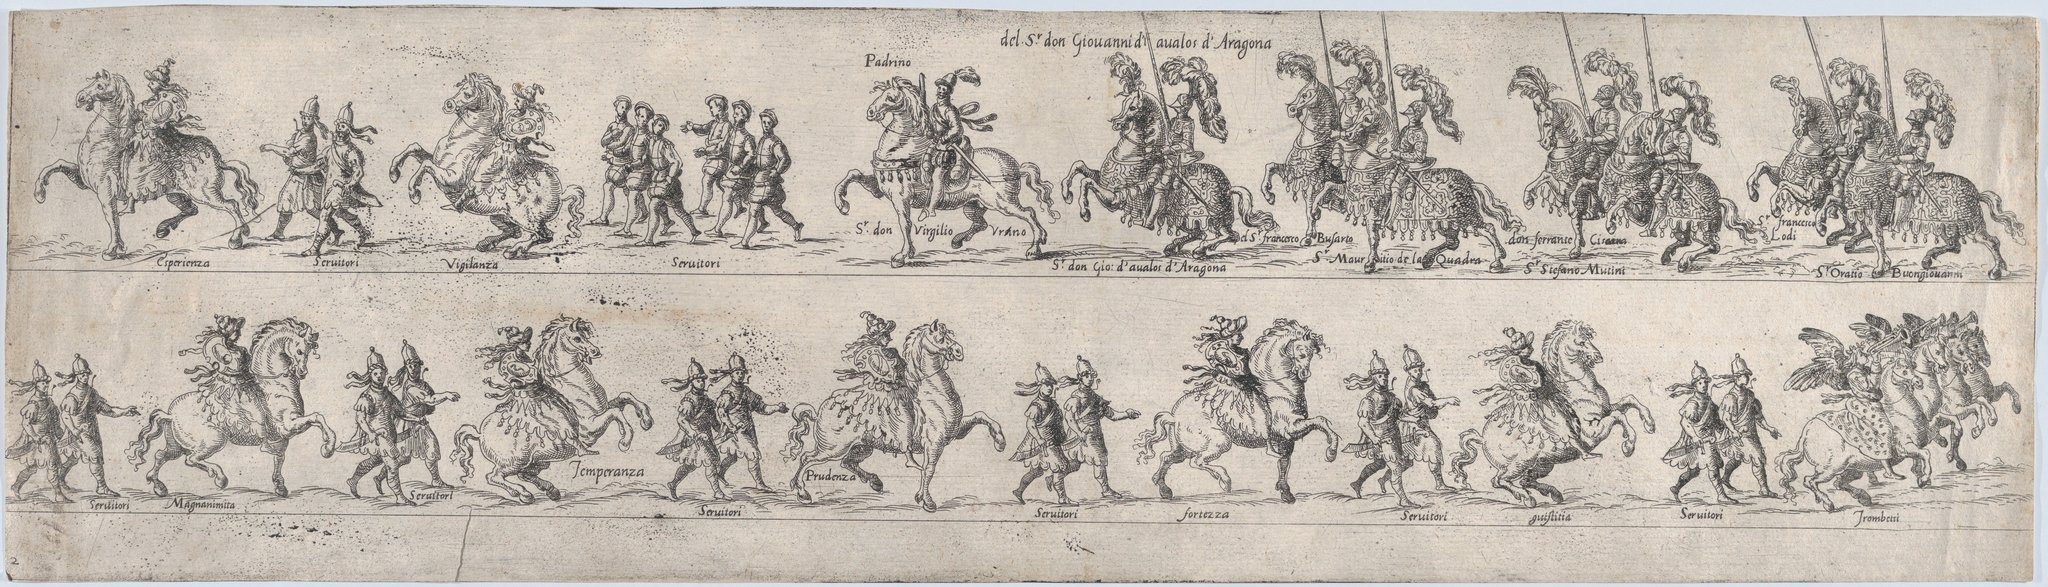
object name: print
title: Plate for Giovanni d'avalos d'Aragona, from a series of twelve showing knights and their attendants dressed for a tournament (plate 2)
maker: Anonymous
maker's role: artist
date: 1565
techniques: etching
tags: soldiers,horses,knights